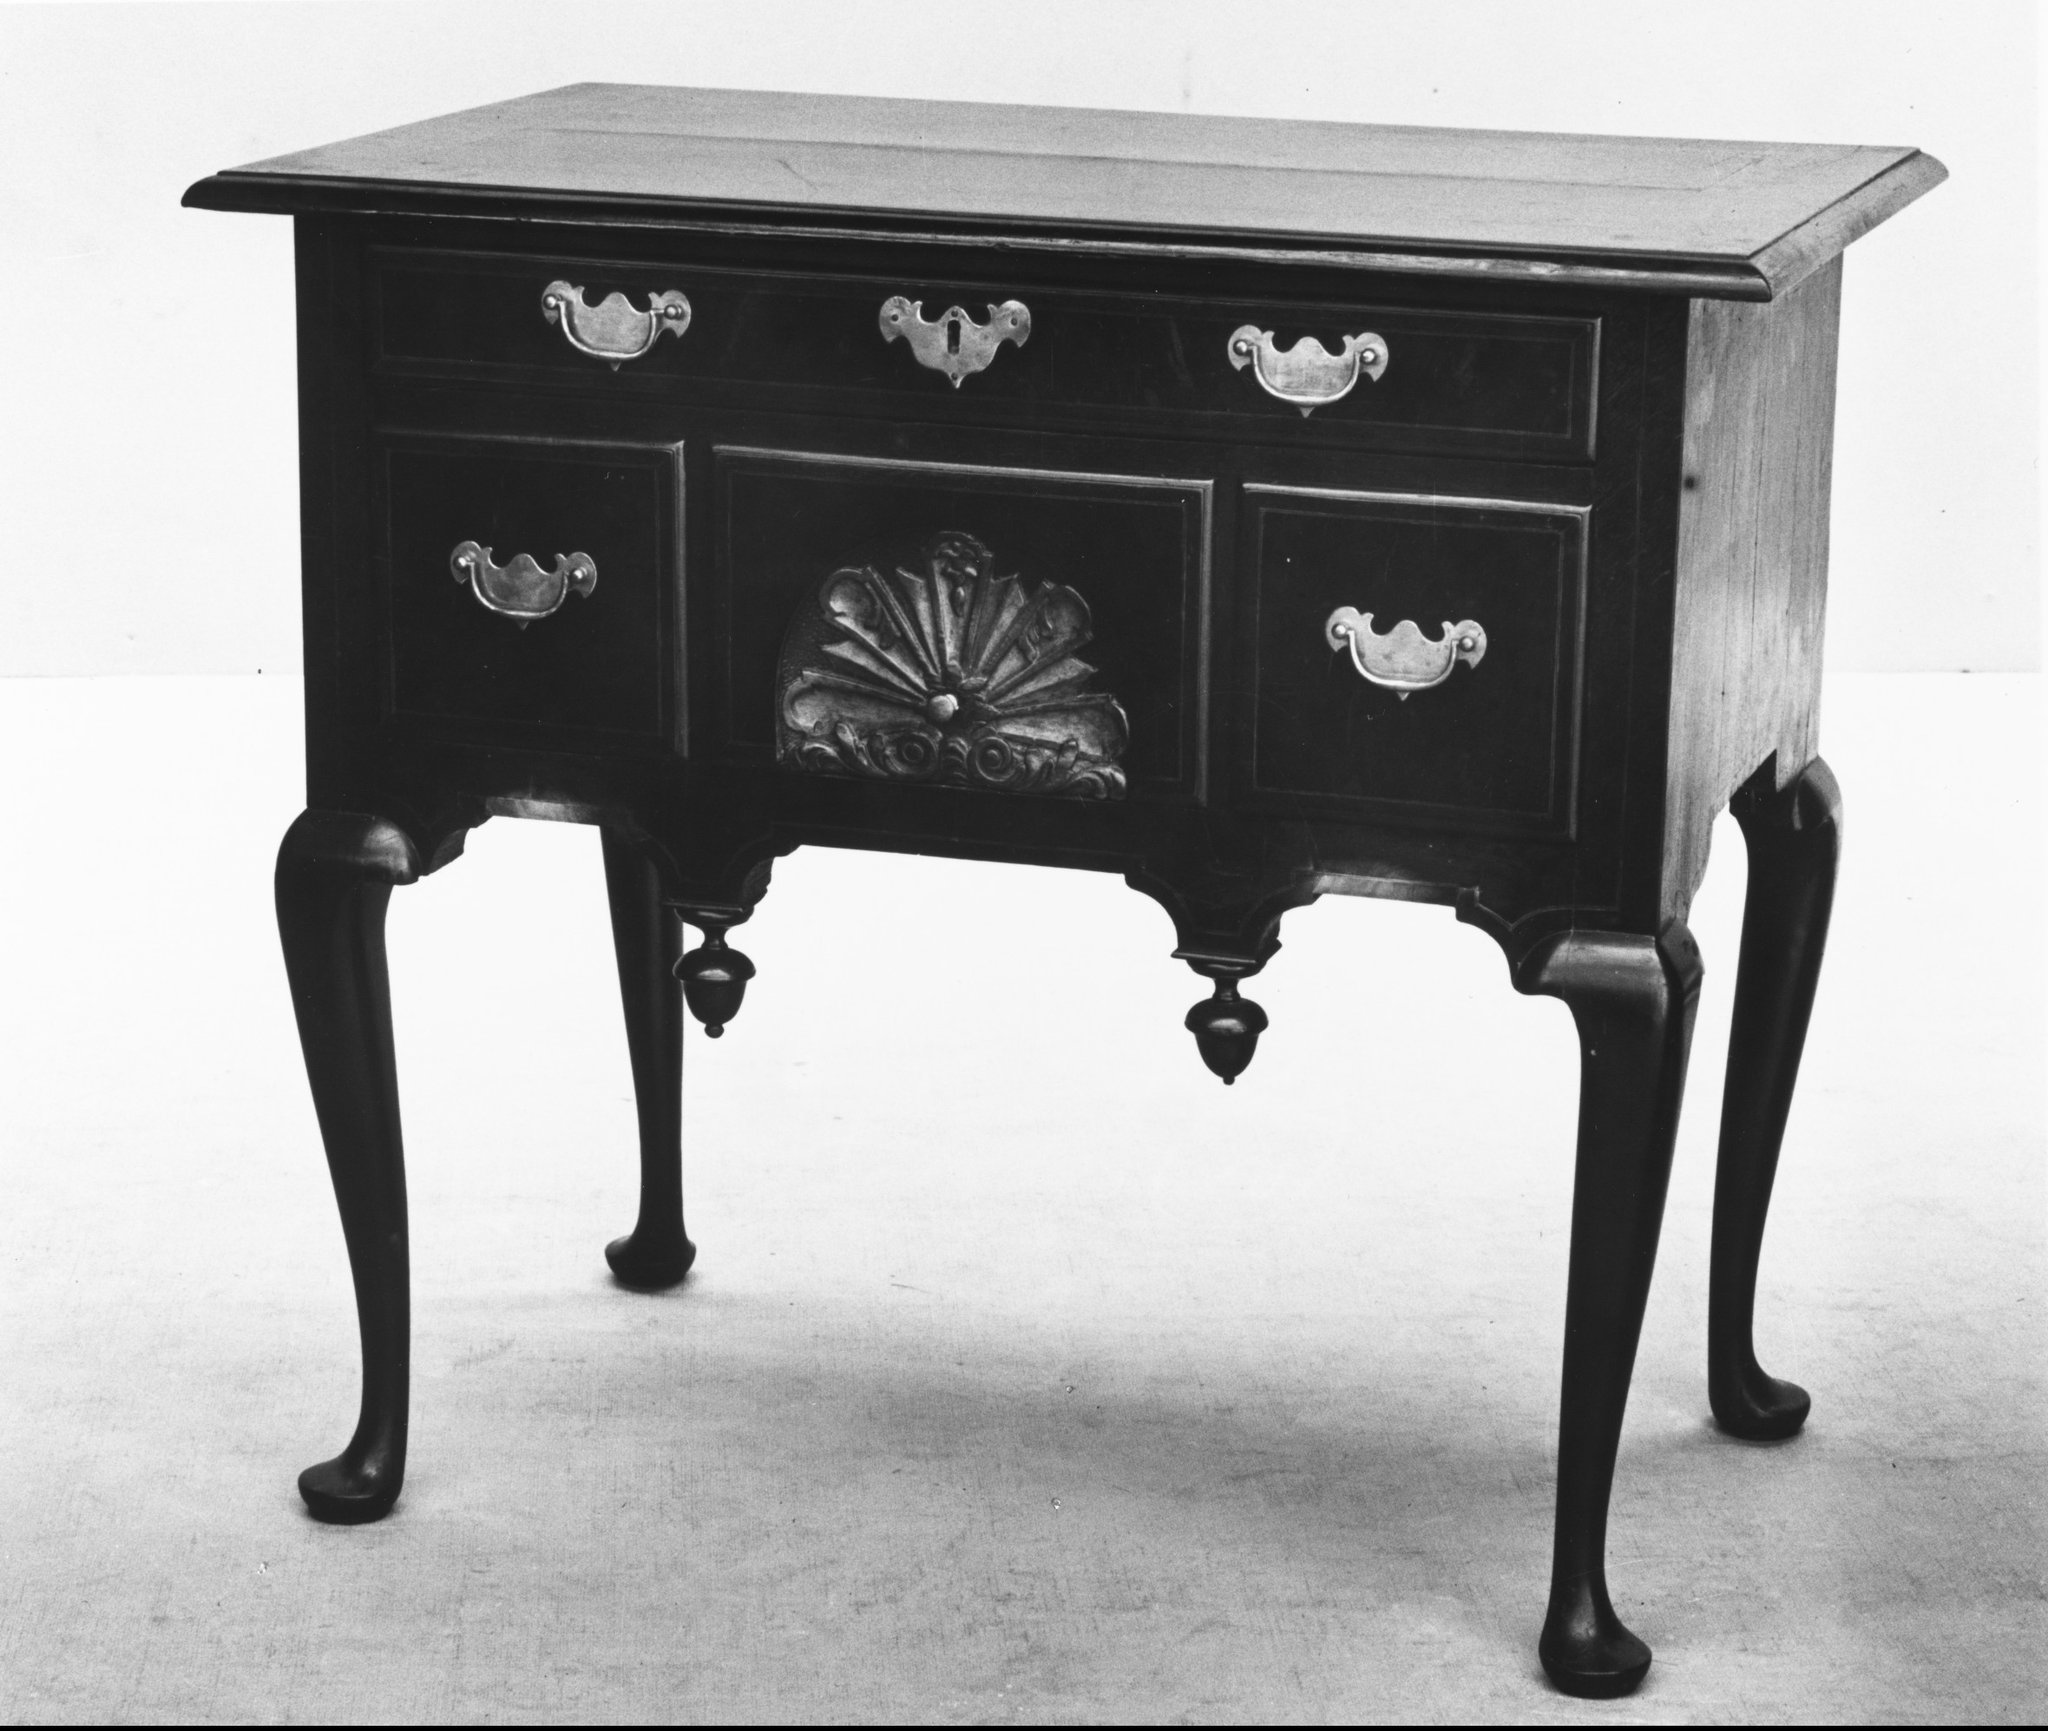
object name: dressing table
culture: american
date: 1730-1760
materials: wood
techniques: veneering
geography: united states